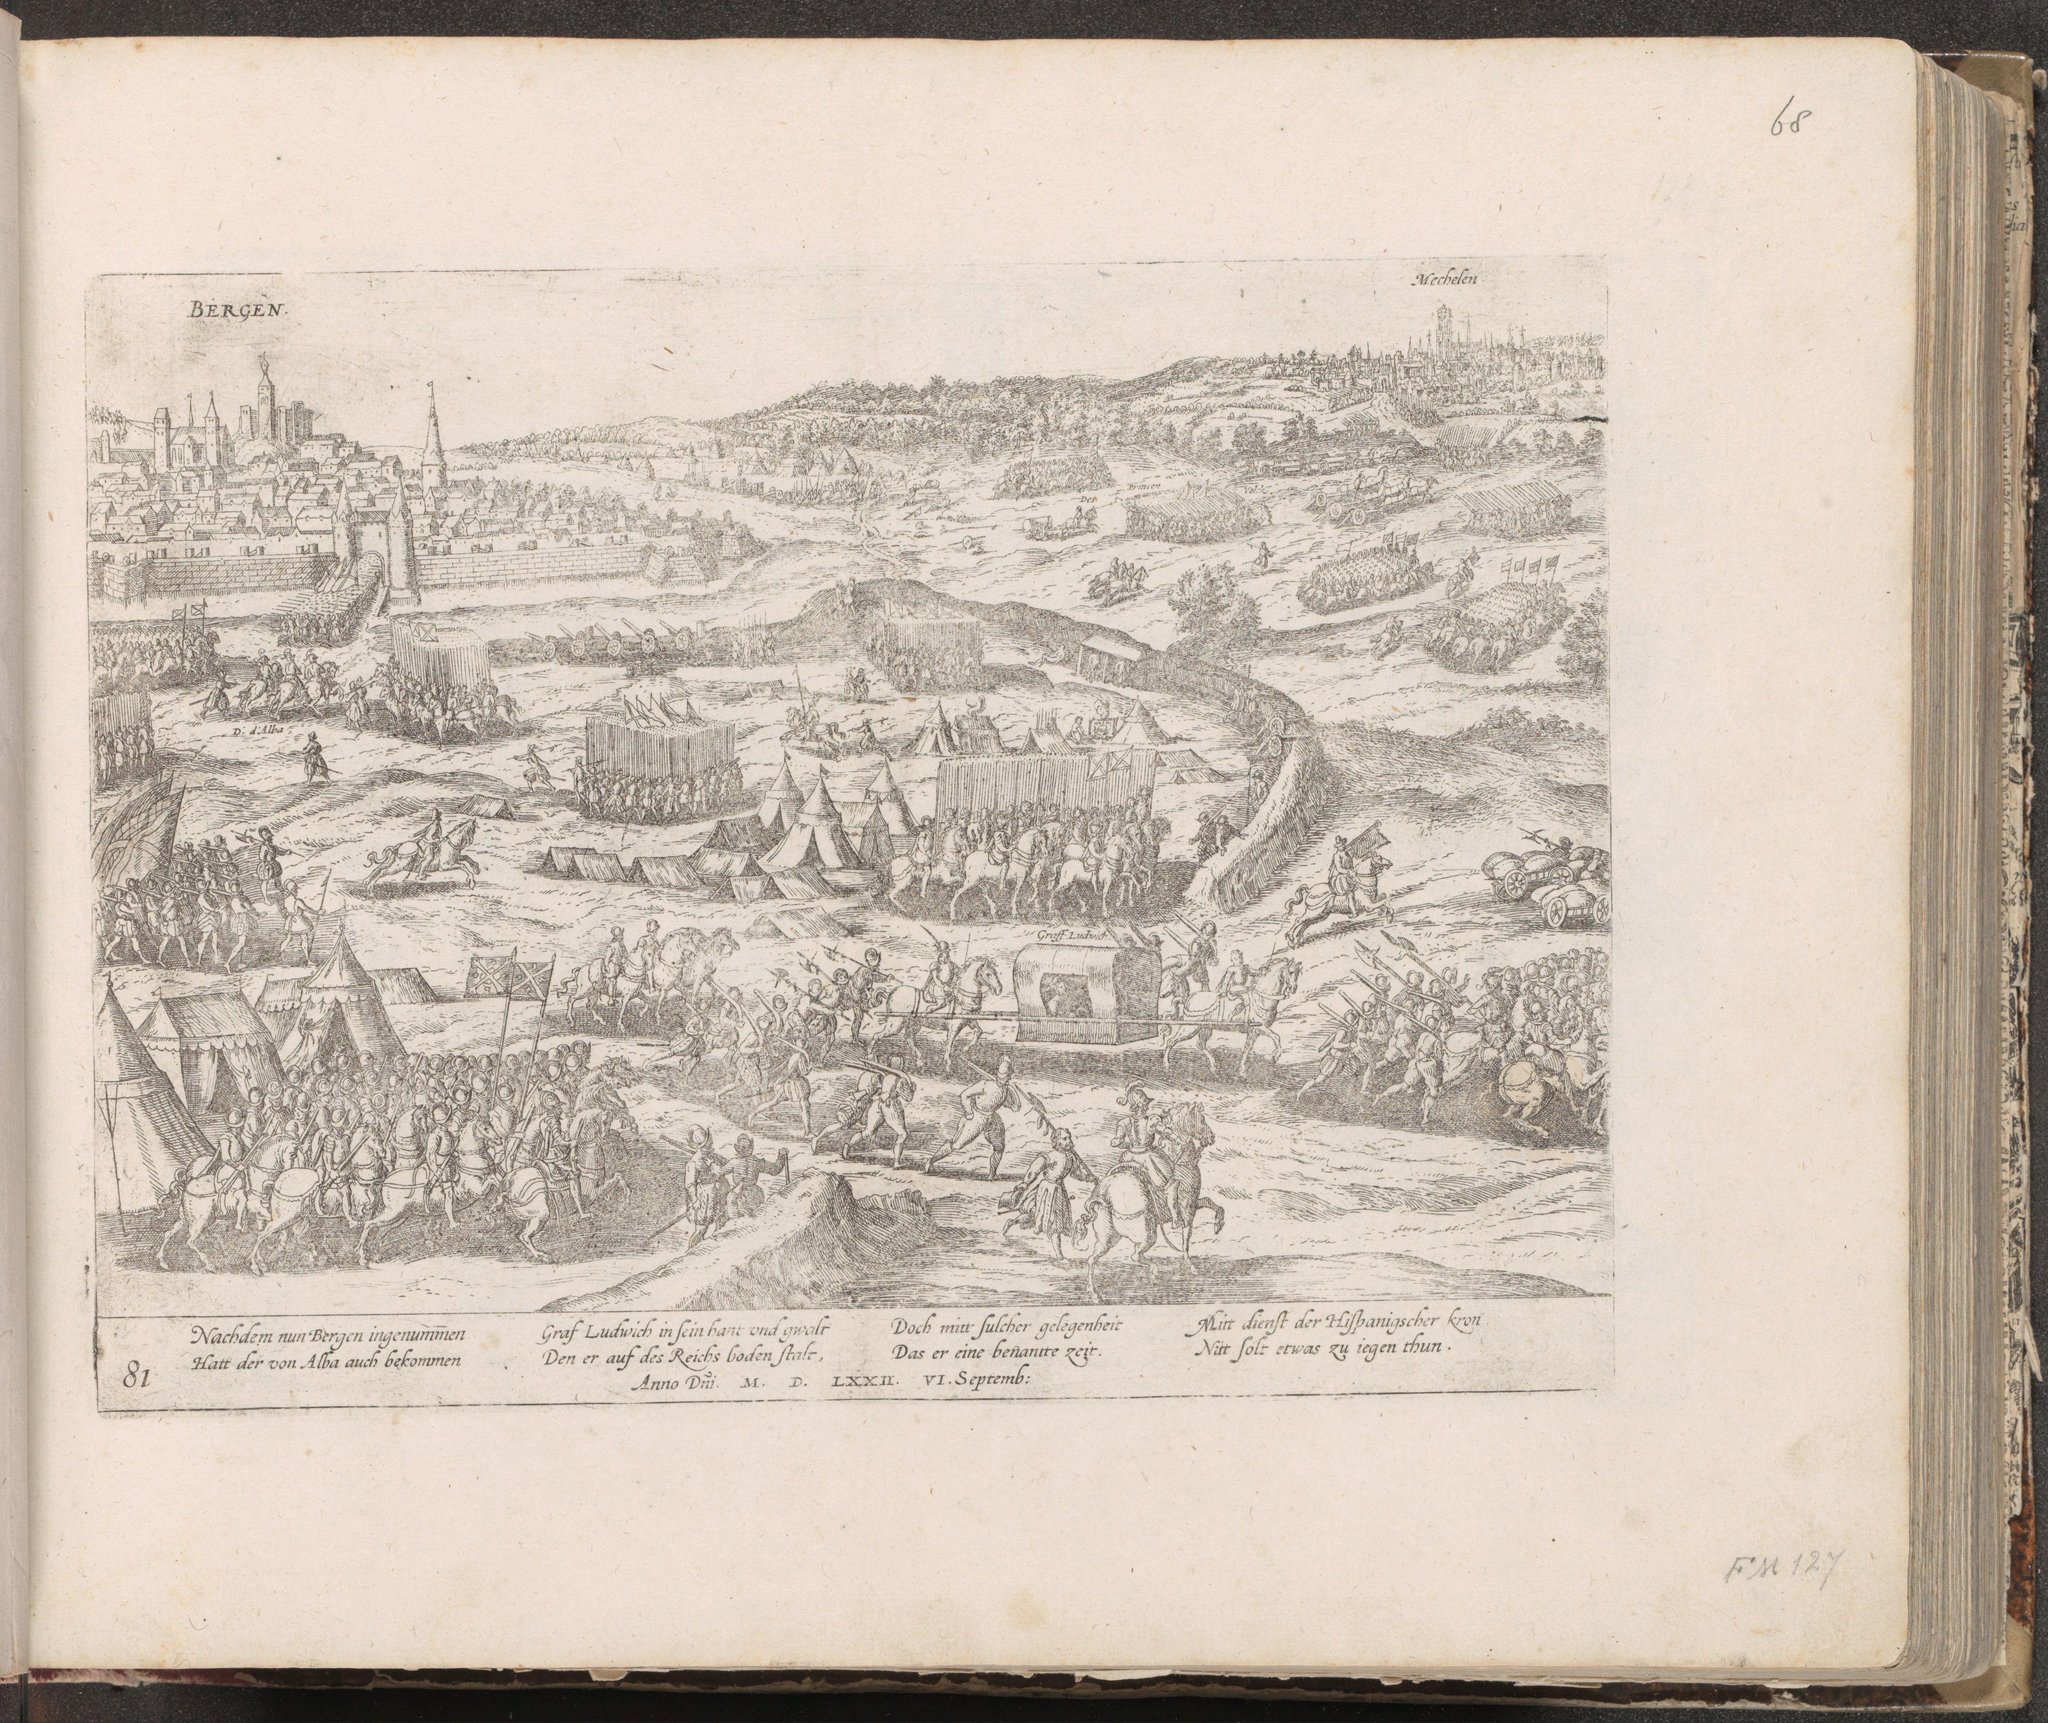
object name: album leaf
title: Lodewijk van Nassau verlaat Bergen, 1572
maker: frans hogenberg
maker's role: print maker, publisher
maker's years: 1538-1590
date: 1574-1578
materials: paper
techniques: etching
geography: cologne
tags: fernando álvarez de toledo (3rd duke of alba), capture of city (after the siege), mechelen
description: Het leger van Lodewijk van Nassau verlaat Bergen, 6 september 1572. Links in de verte neemt het leger van Alva de stad weer in, rechts in de verte Mechelen. Op de voorgrond Lodewijk in een draagstoel. Met onderschrift van 8 regels in het Duits. Linksonder genummerd: 81. De prent maakt deel uit van een album.